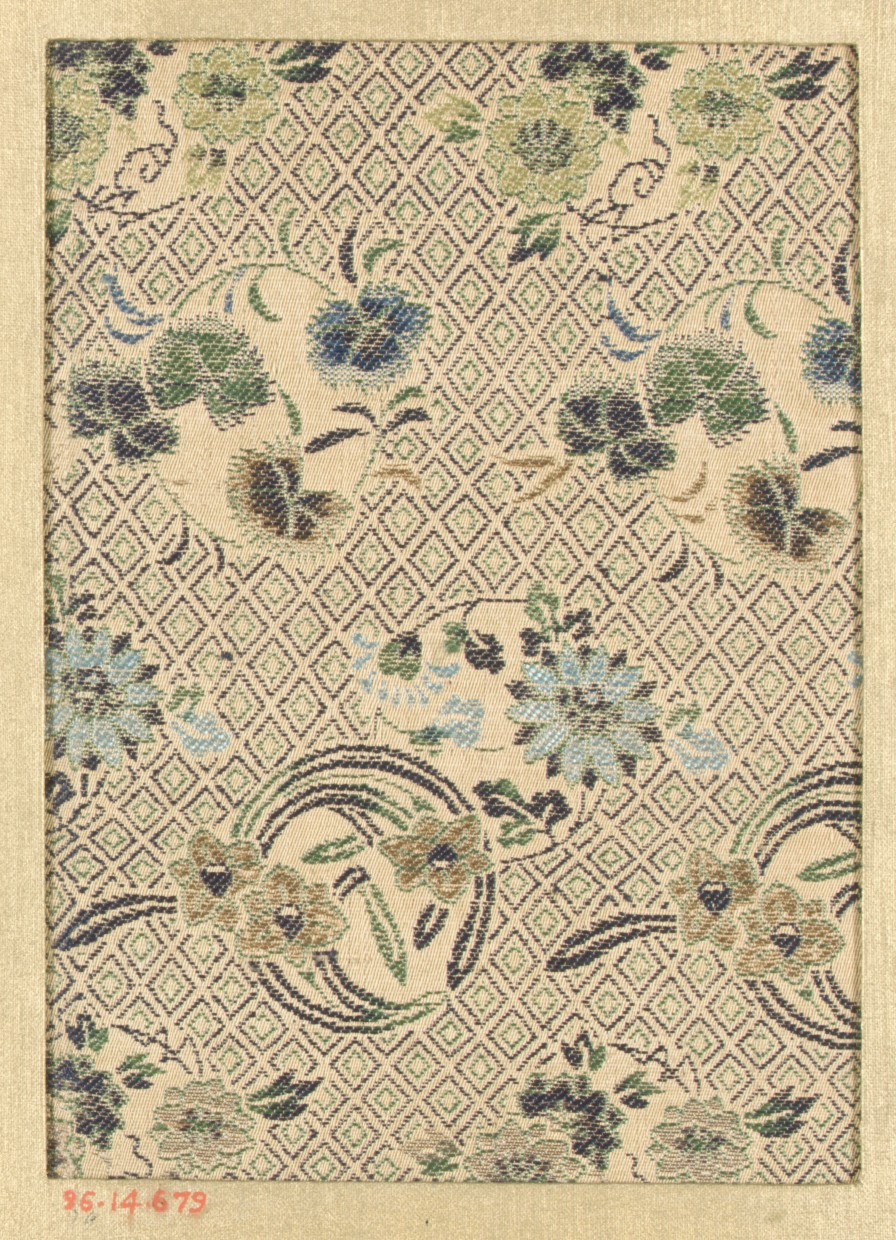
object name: piece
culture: japanese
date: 1701-1900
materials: silk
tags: flowers